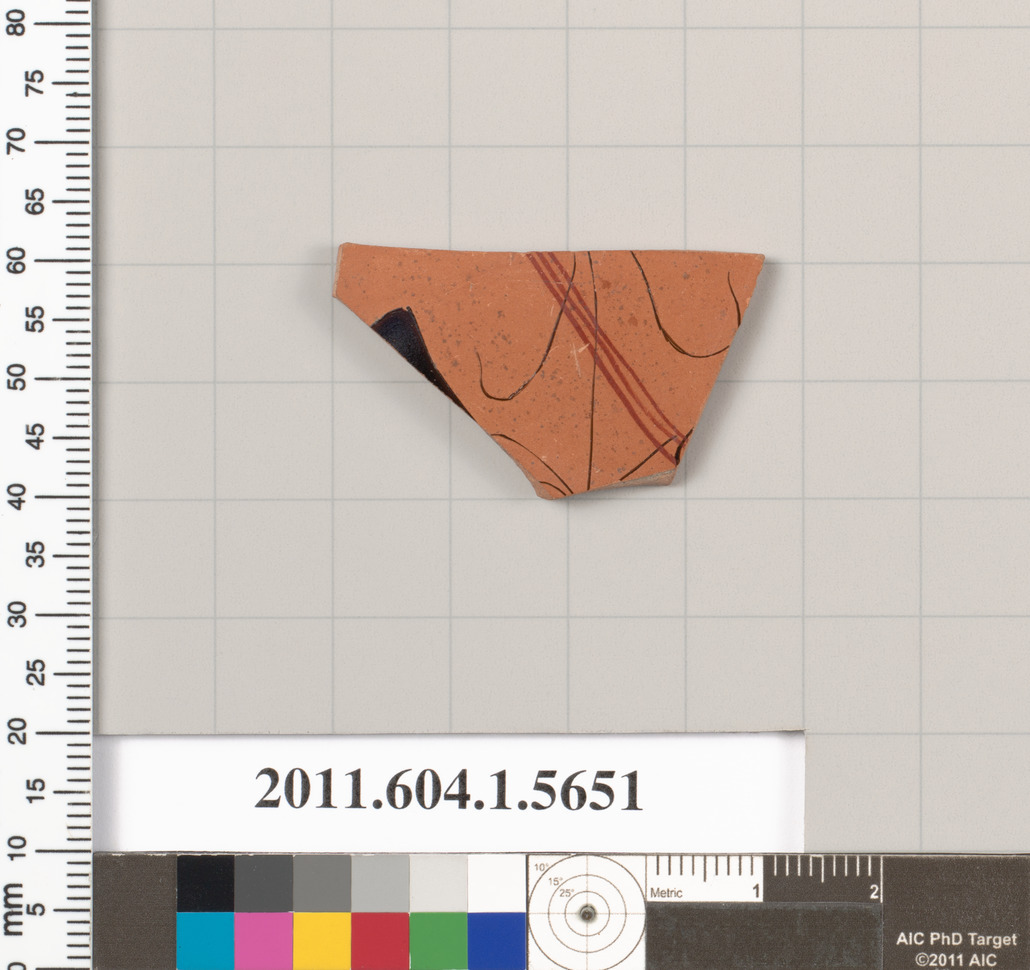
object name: kylix fragment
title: Terracotta fragment of a kylix (drinking cup)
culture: greek, attic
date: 500-480 BCE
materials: terracotta